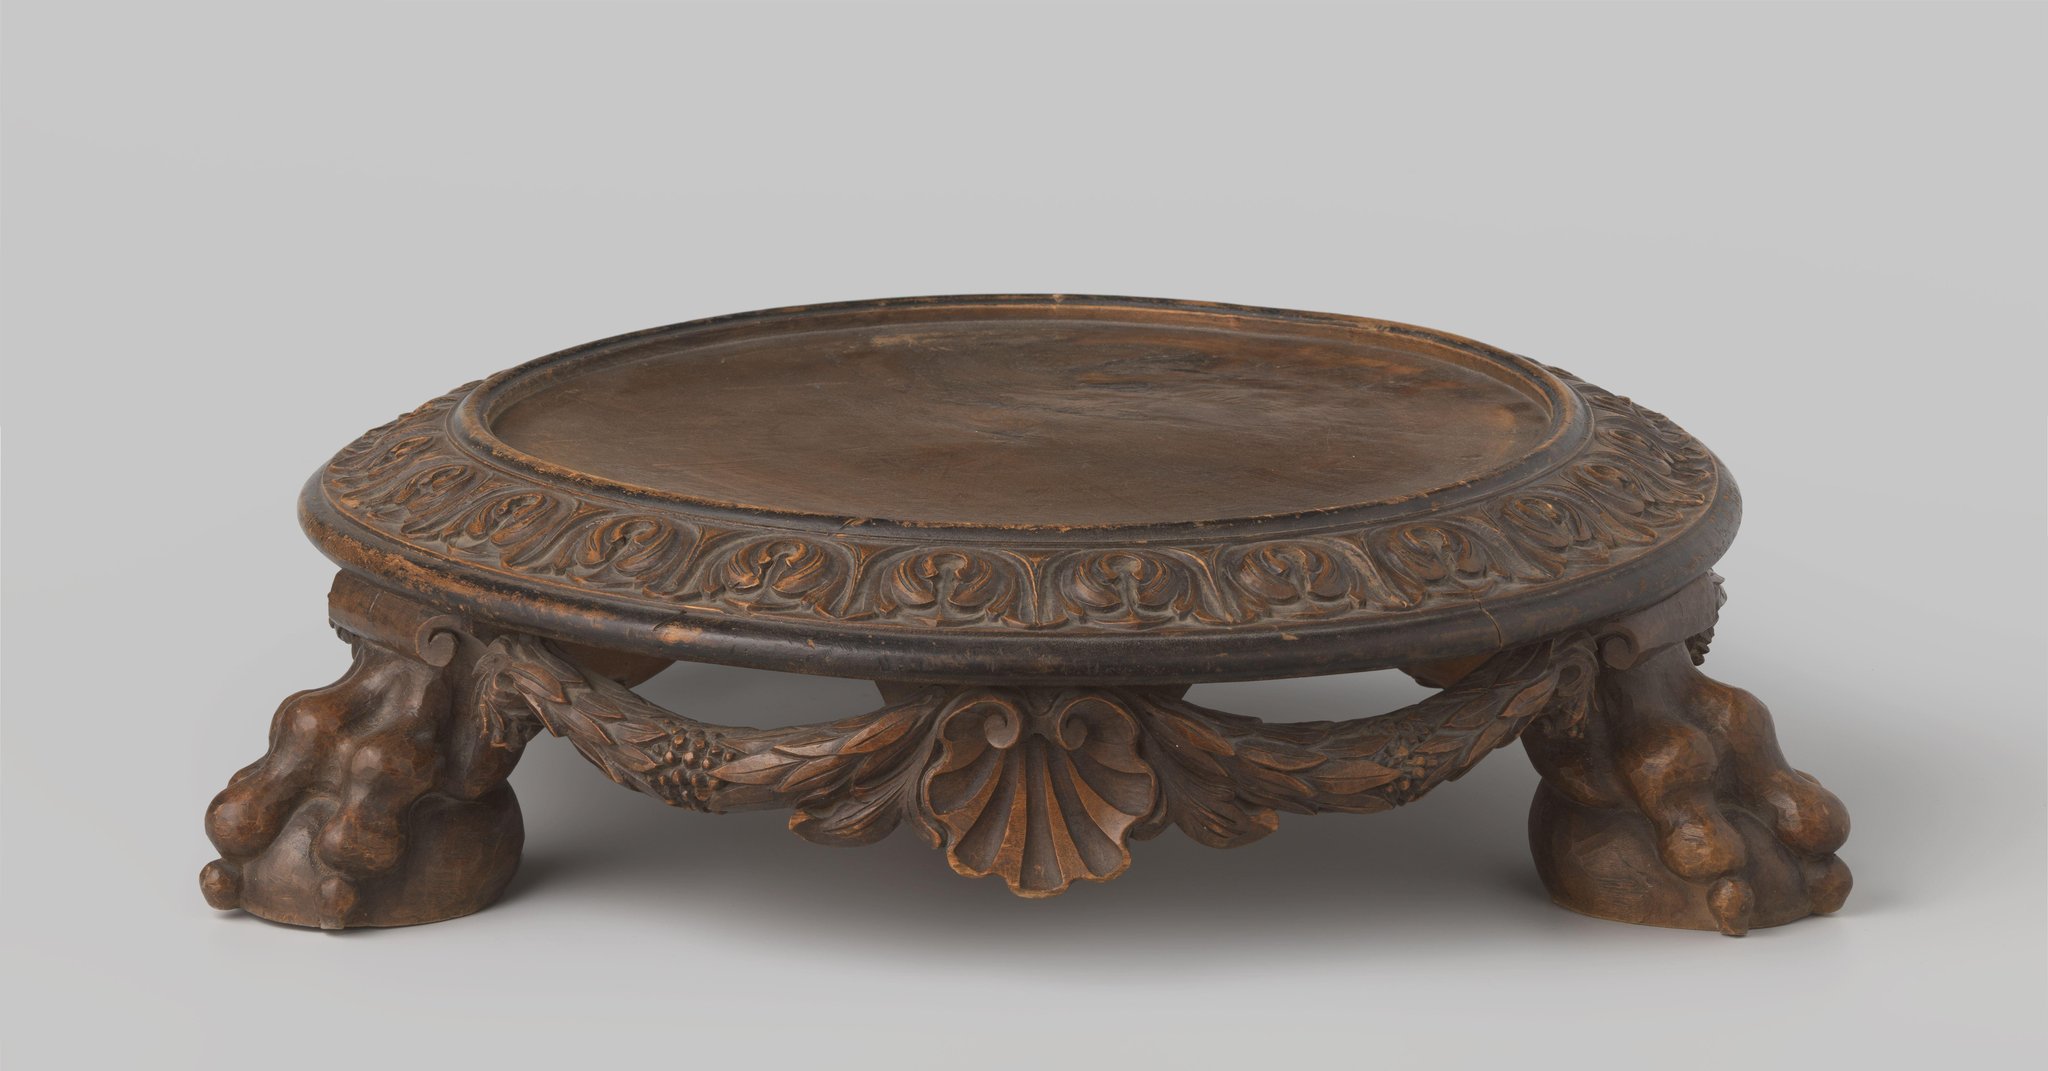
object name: furniture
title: Meubilair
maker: Anonymous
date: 1800-1900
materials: wood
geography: northern netherlands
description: Rond voetstuk van hout voor een porseleinen vaas, rustend op drie leeuweklauwen, waartussen dubbele festoenen met een schelp in het midden. De geprofileerde bovenrand is versierd met een bladmotief.